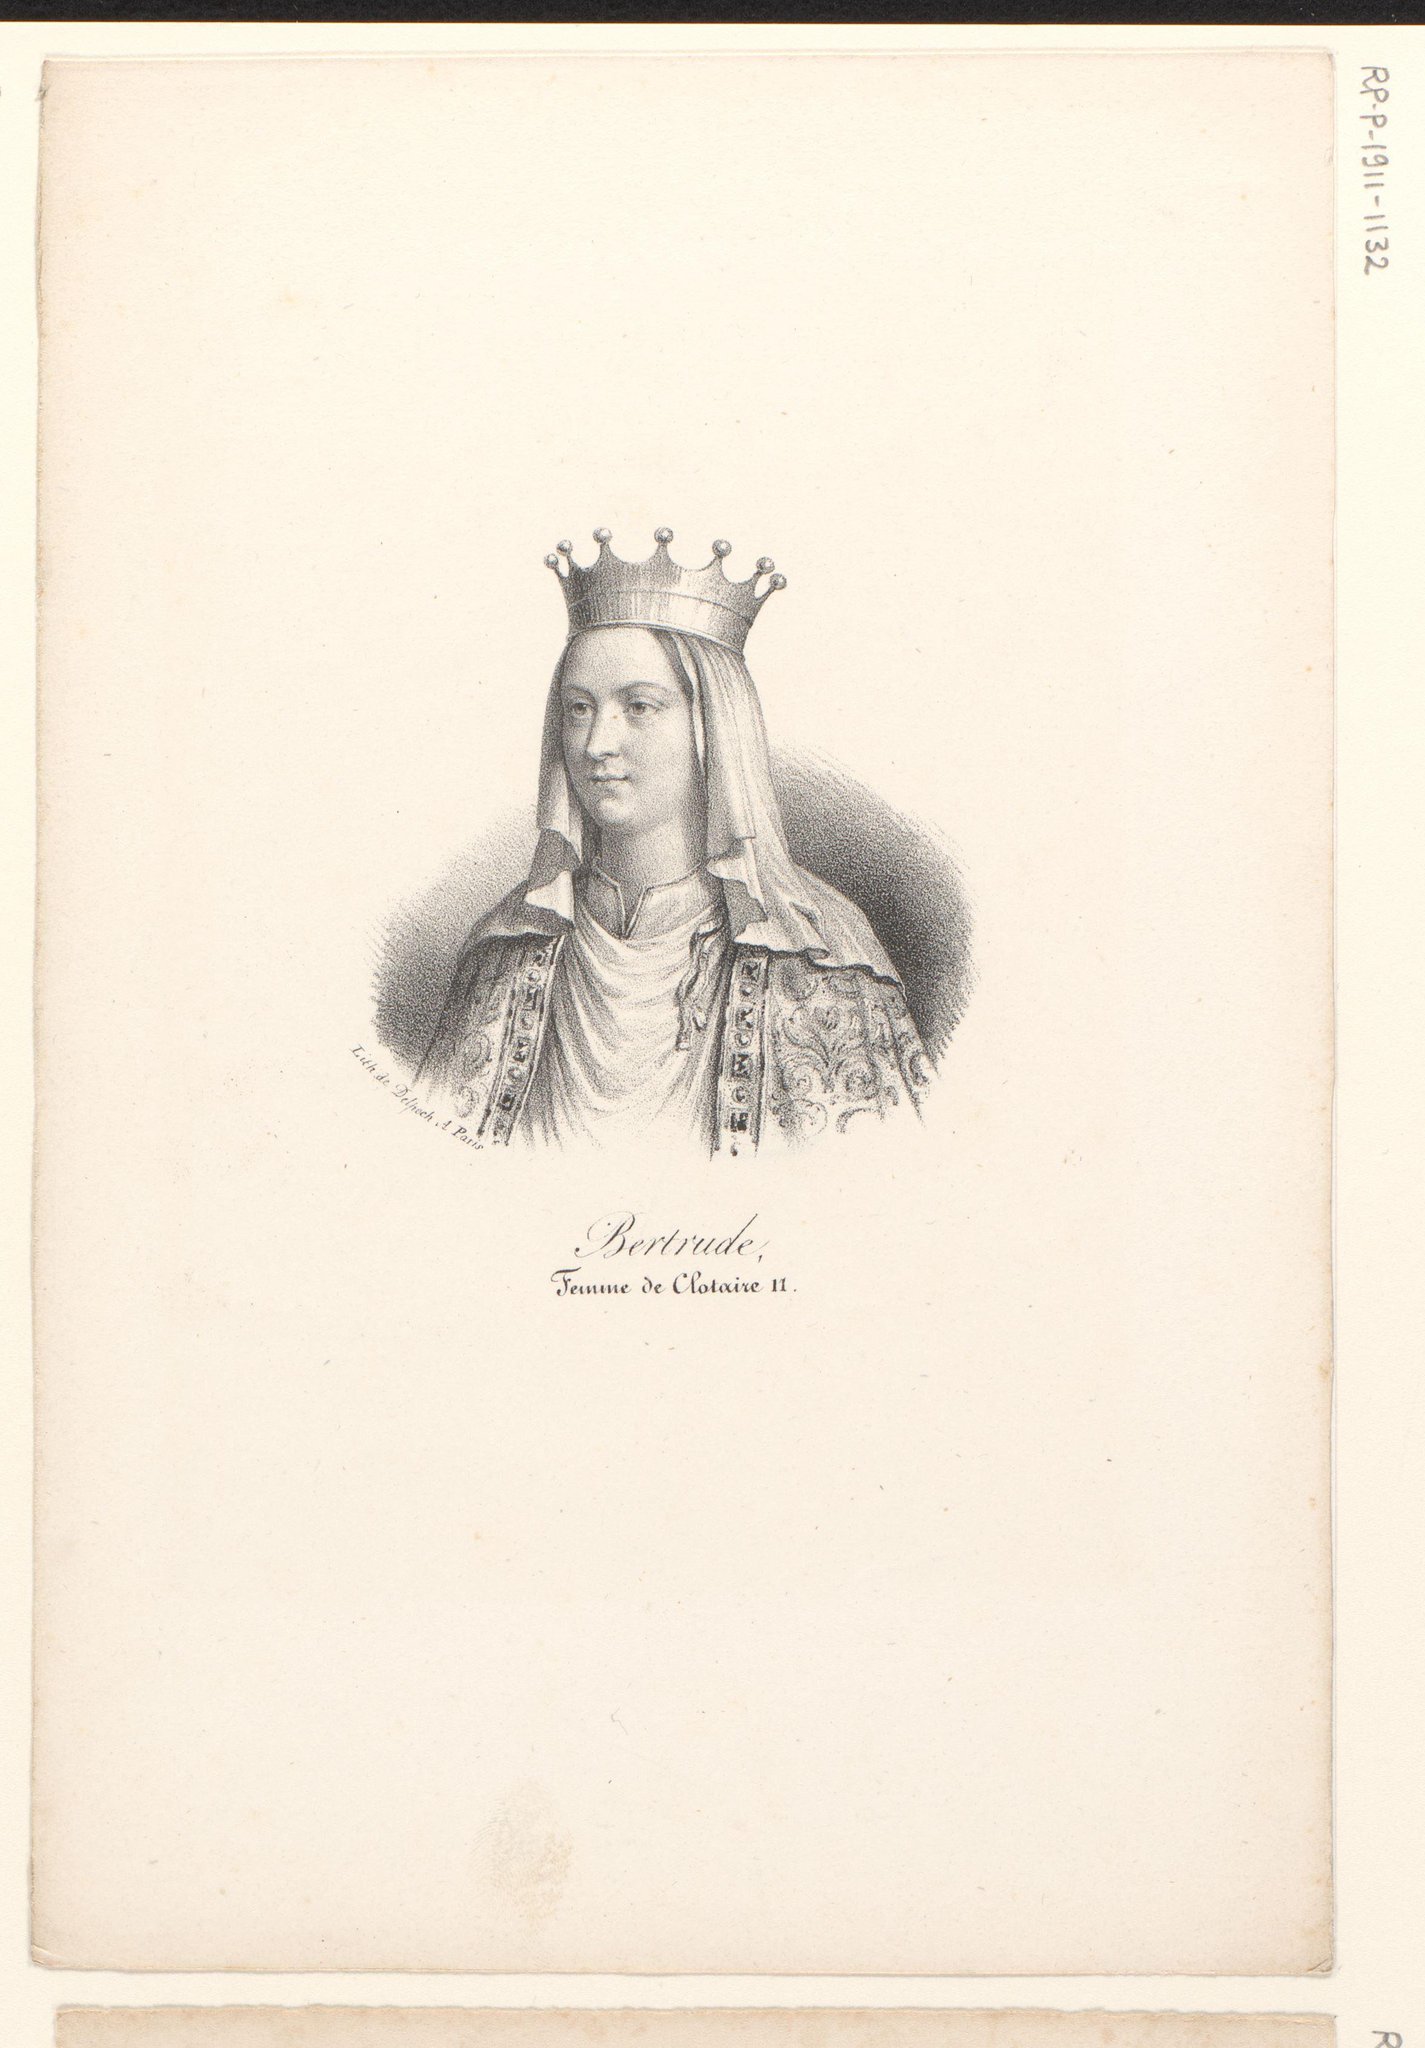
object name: print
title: Portret van Bertrude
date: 1818-1842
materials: paper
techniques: lithograph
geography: paris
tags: historical persons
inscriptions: collector's mark: Lugt 2228a